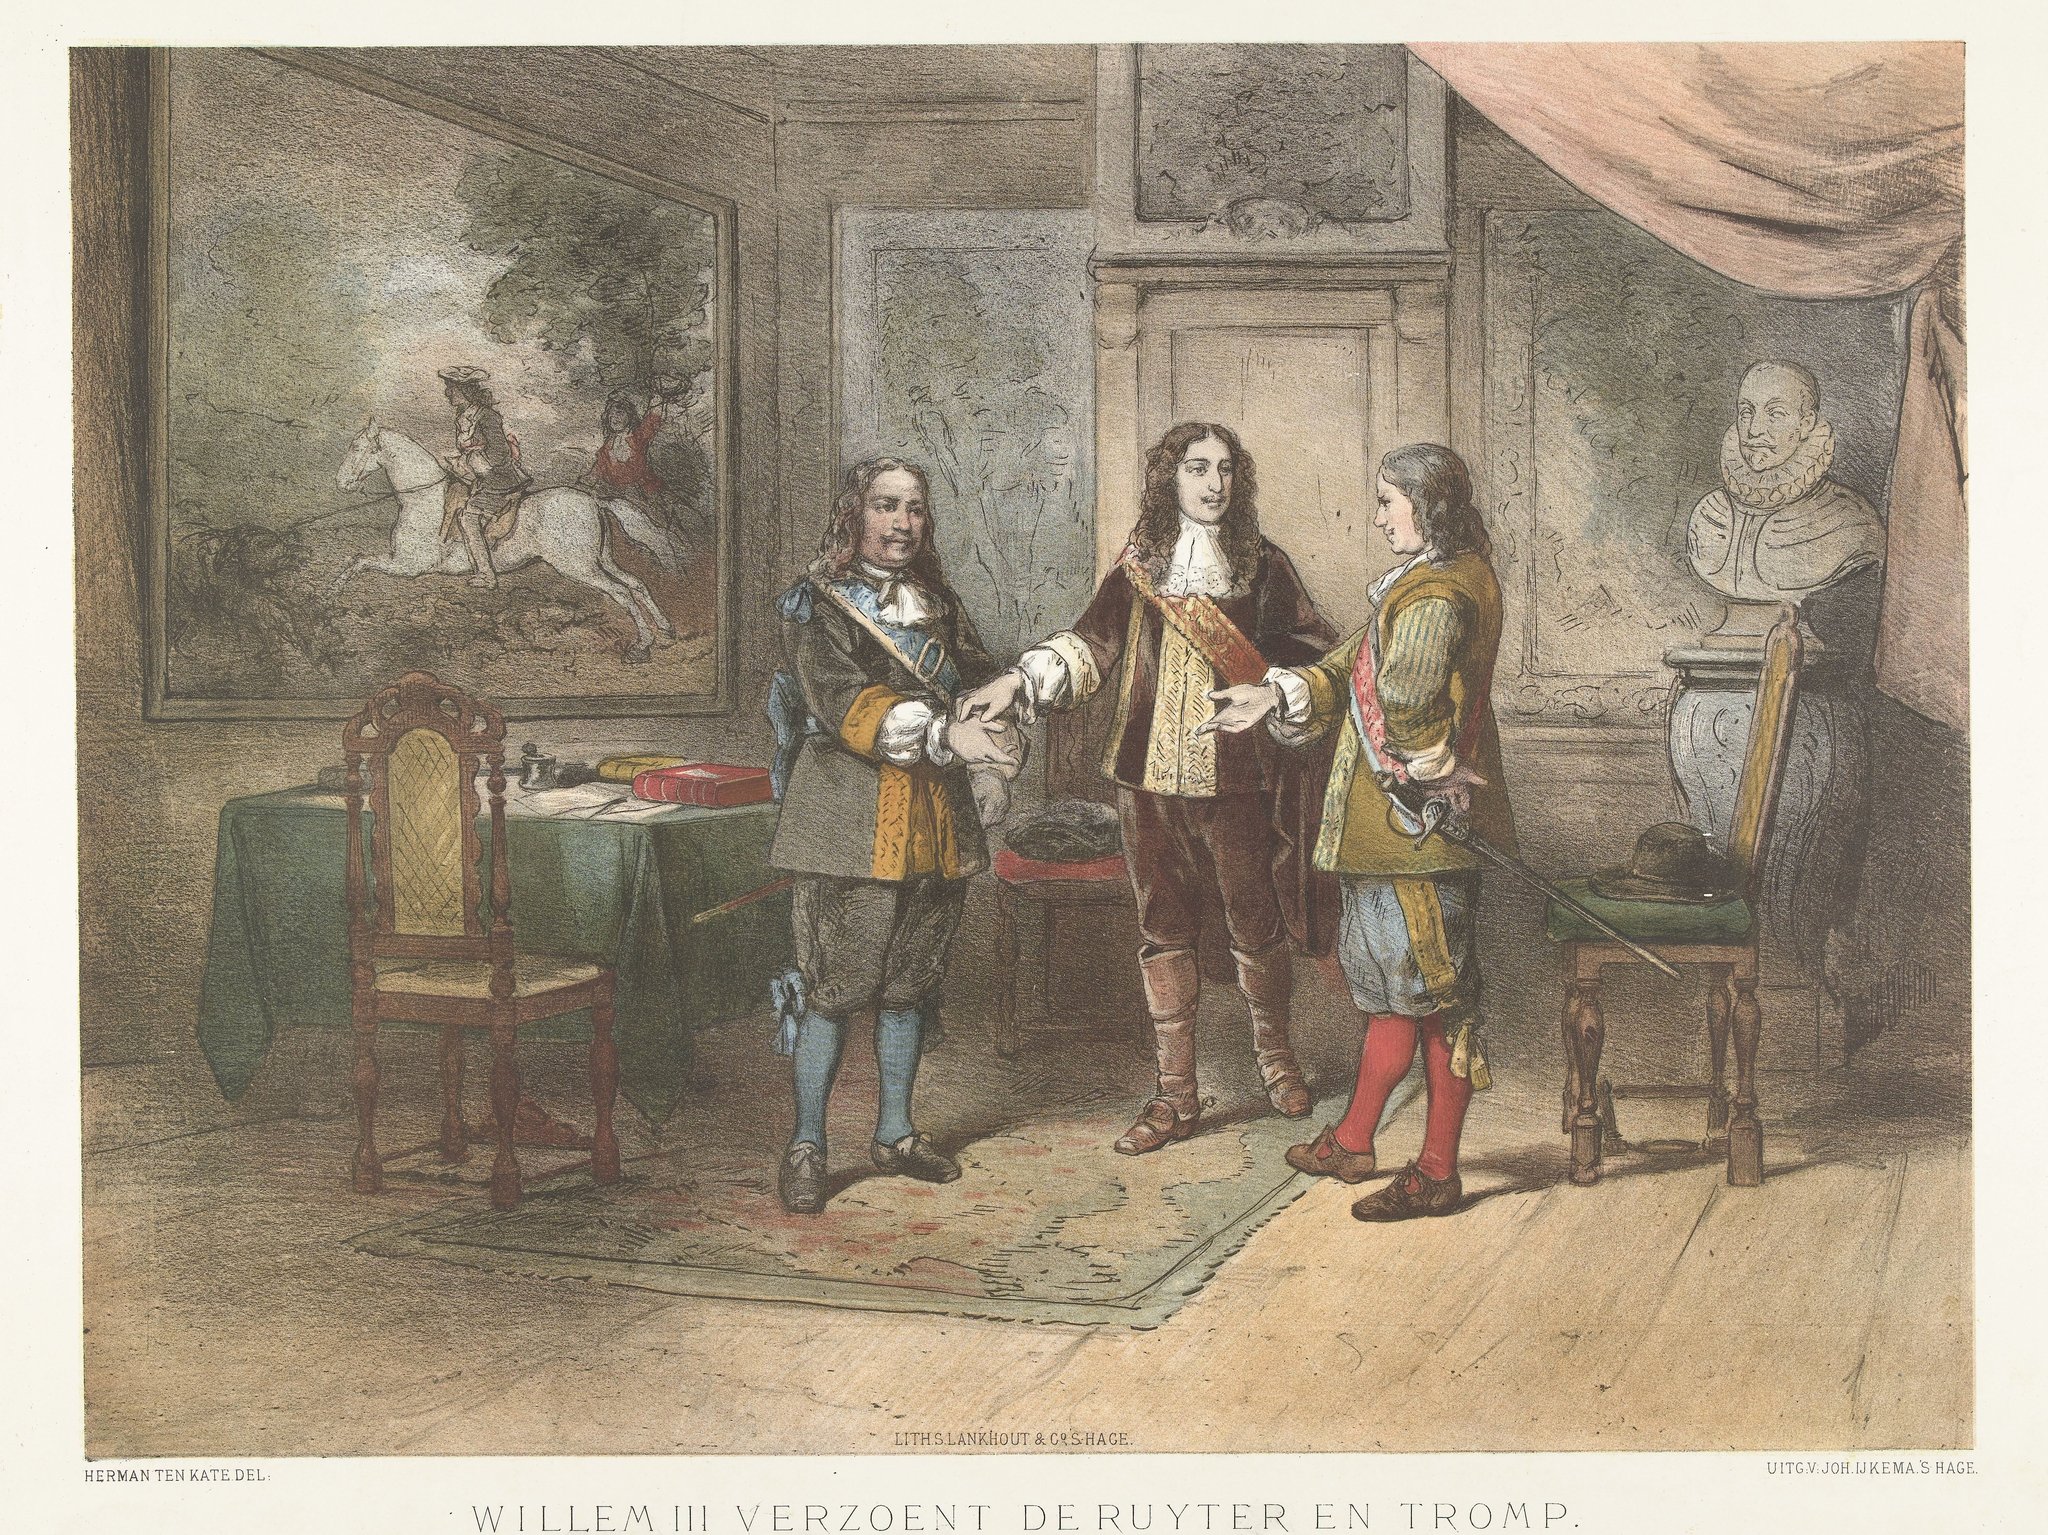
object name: print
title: Prins Willem III verzoent Michiel Adriaenszoon de Ruyter en Cornelis Tromp, 1673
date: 1877-1891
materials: paper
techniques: lithograph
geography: the hague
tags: michiel adriaenszoon de ruyter, rotterdam, amsterdam, cornelis tromp, william iii (prince of orange and king of england, scotland, and ireland), reconciliation, audition; ruler giving audience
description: Prins Willem III verzoent de admiraals Michiel Adriaenszoon de Ruyter en Cornelis Tromp met elkaar, april 1673. Interieur van een studeerkamer met schilderij met jachtscène en buste van Willem van Oranje.